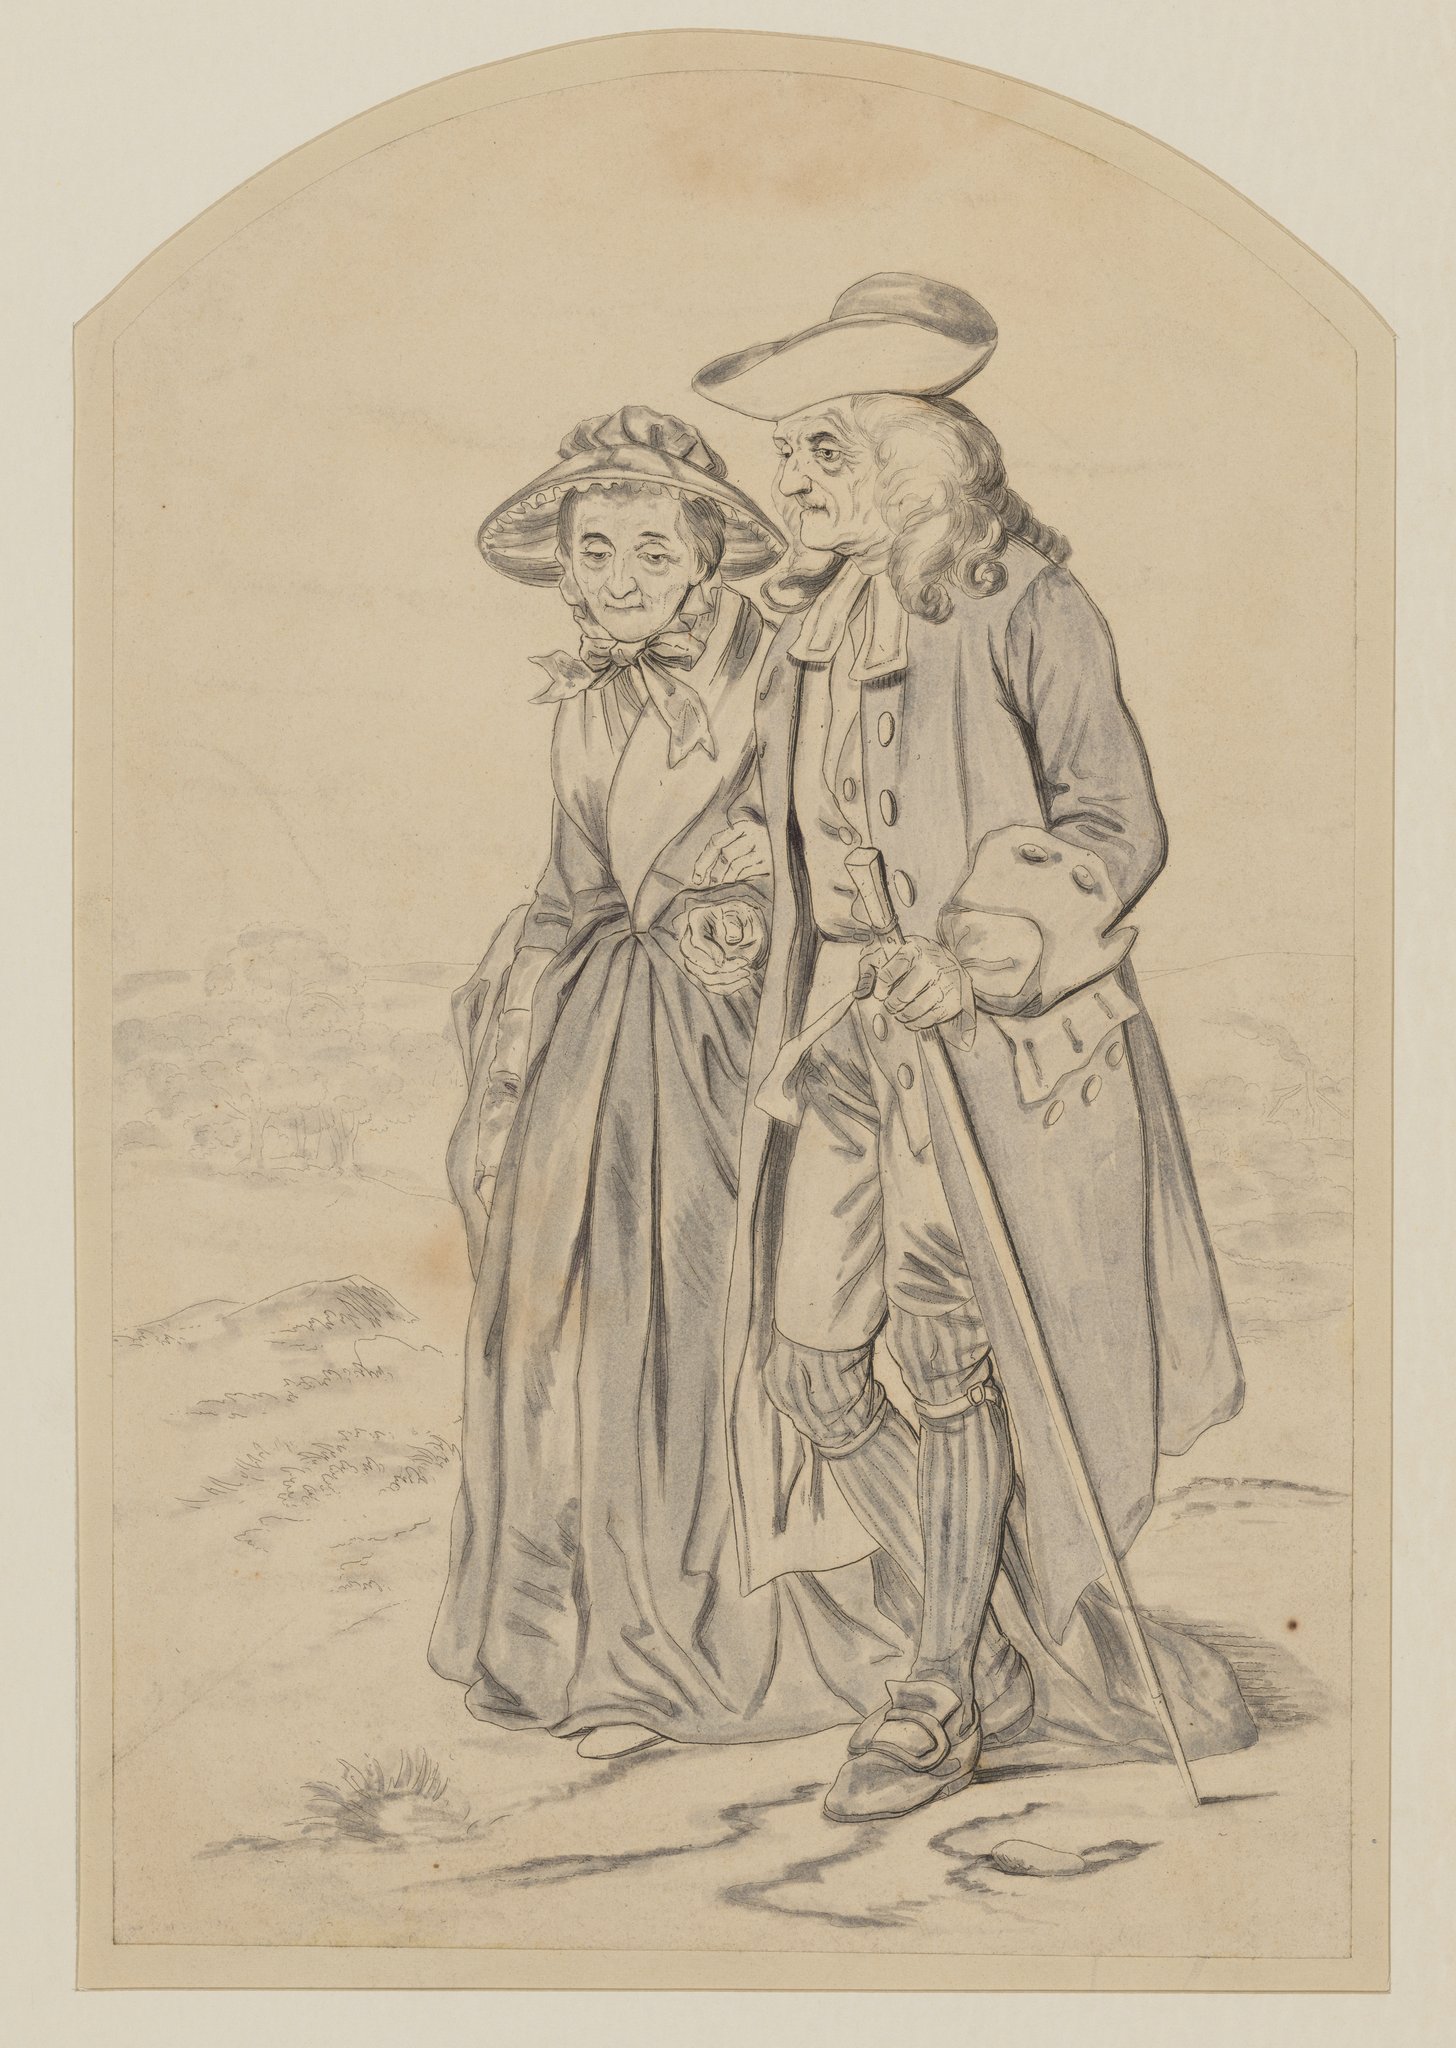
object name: drawing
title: Parson Wells and his Wife, from Judd's "Margaret: A Tale of the Real and Ideal, Blight and Bloom"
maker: felix octavius carr darley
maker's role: artist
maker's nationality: american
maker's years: 1822-1888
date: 1856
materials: ink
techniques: brush, pen, wash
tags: men,women